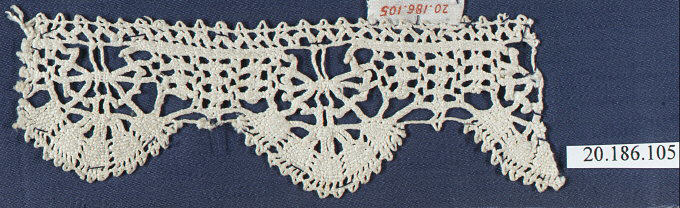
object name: edging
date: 1601-1700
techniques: lace